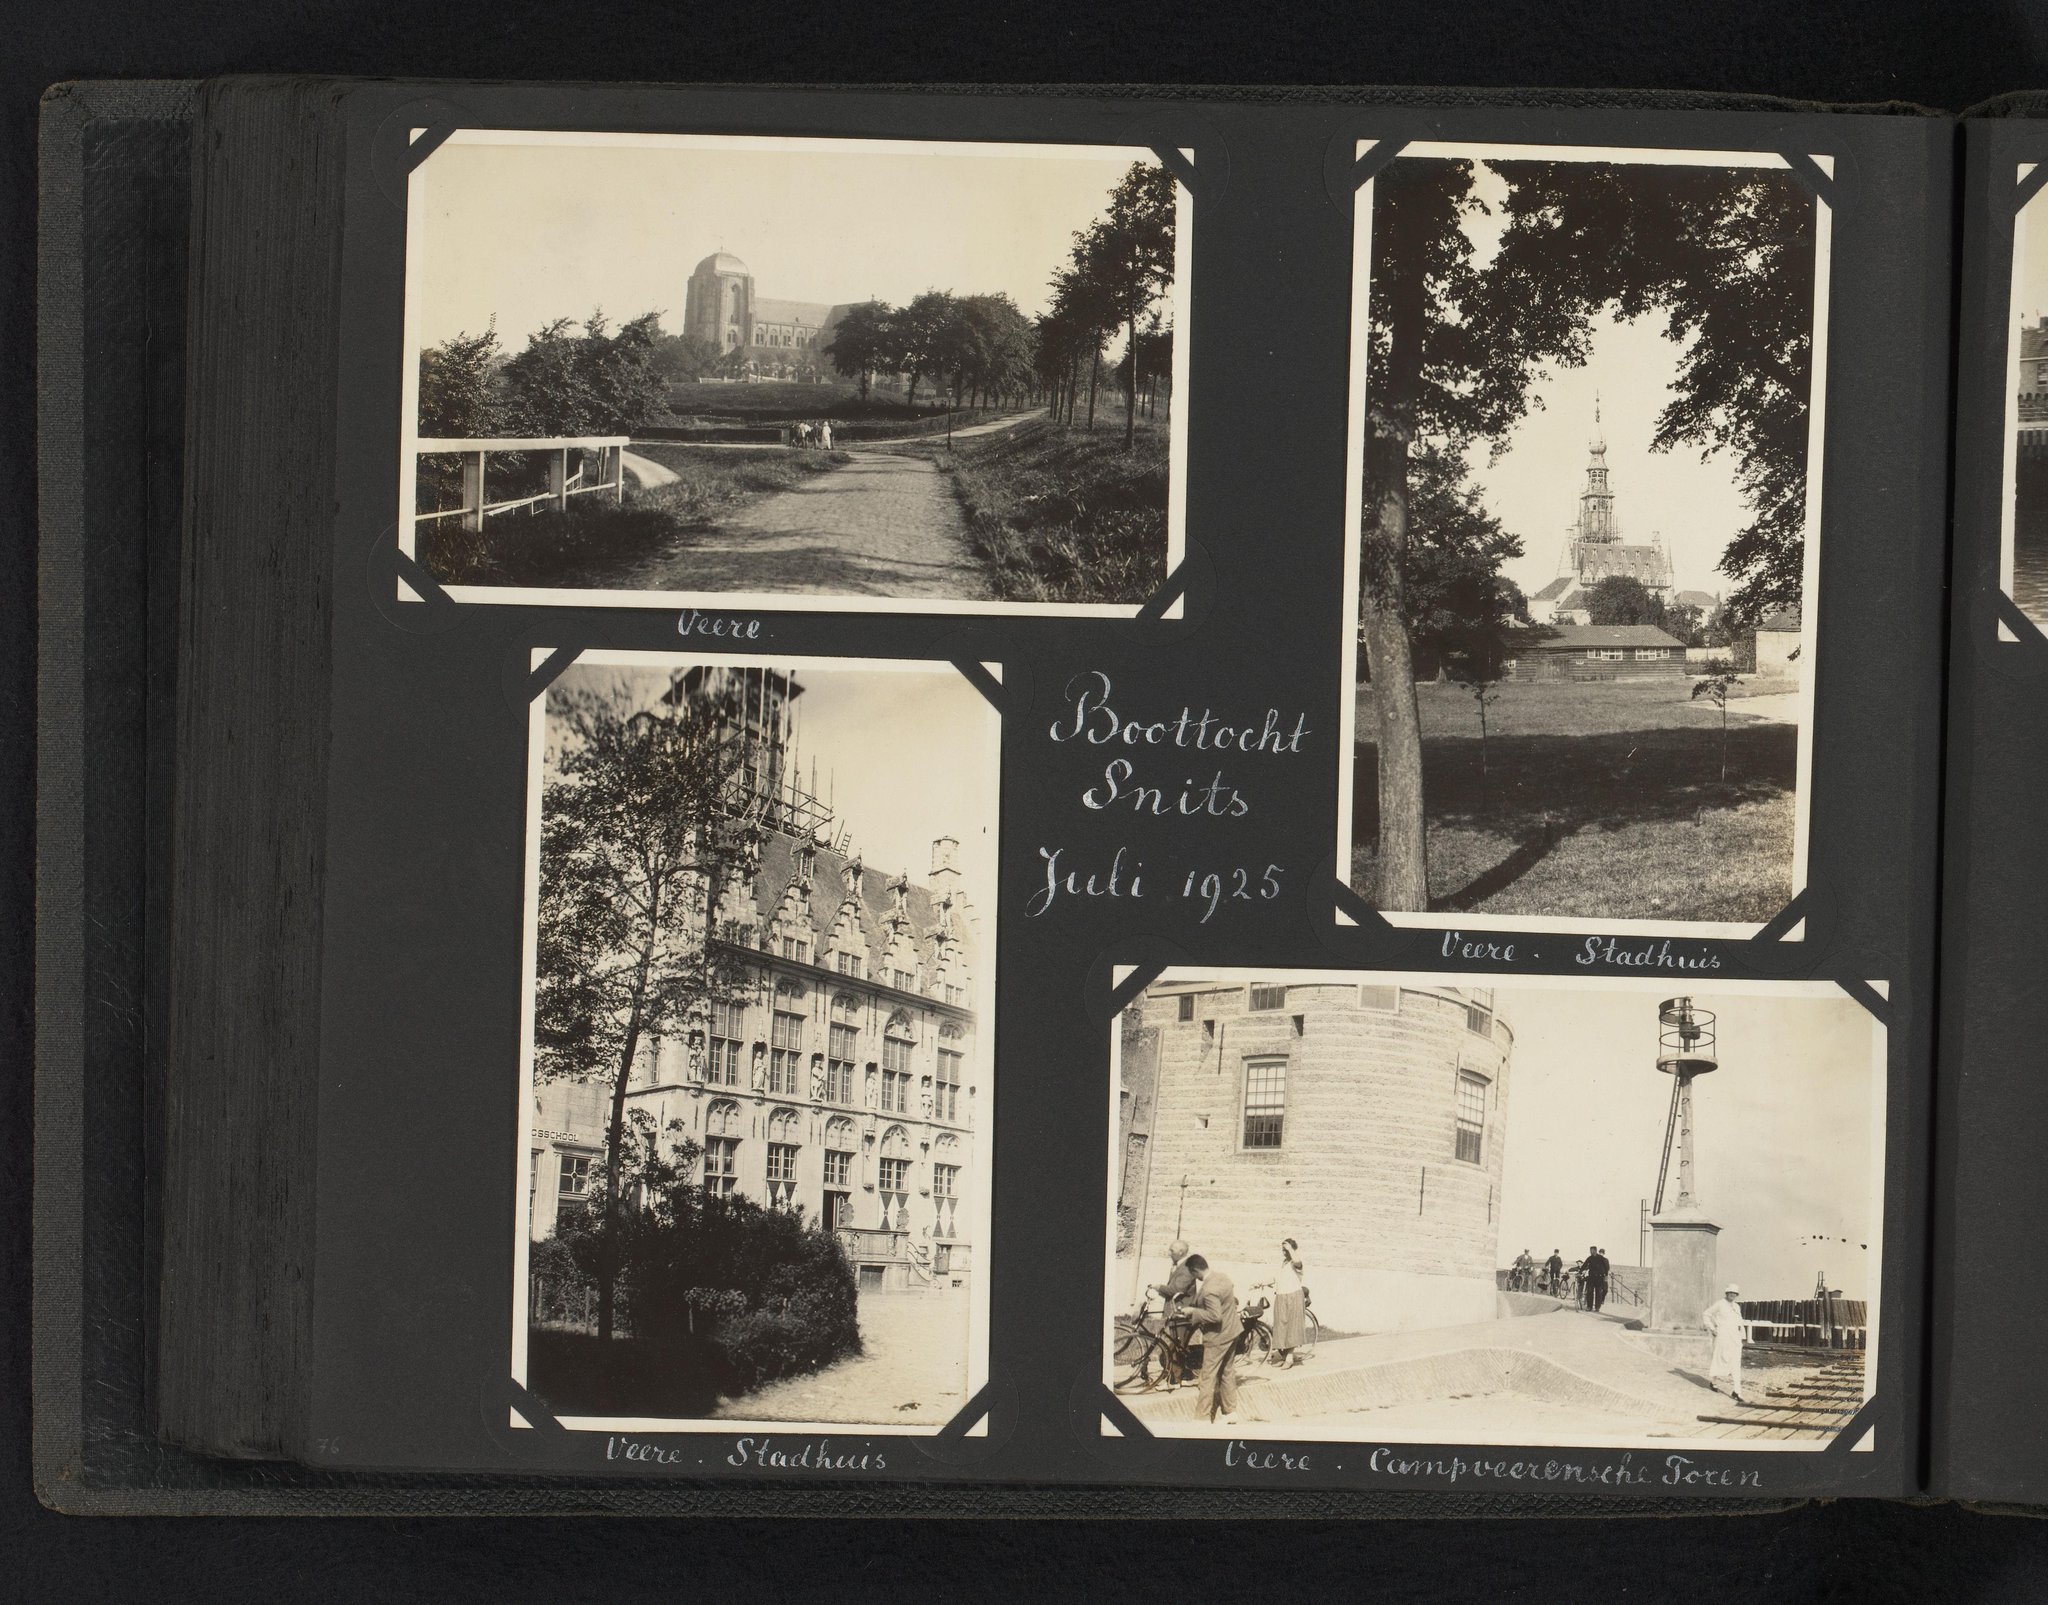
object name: photograph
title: Vier foto's van Veere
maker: hendrik herman van den berg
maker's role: amateurfotograaf, jurist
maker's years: 1875-1944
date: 1907-1925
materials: paper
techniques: gelatin silver print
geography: veere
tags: church (exterior), townhall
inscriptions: inscription: ‘Veere - Campveerensche Toren’, inscription: ‘Veere - Stadhuis’, inscription: ‘Veere’, inscription: ‘Veere - Stadhuis’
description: Deze foto's maken deel uit van een album.